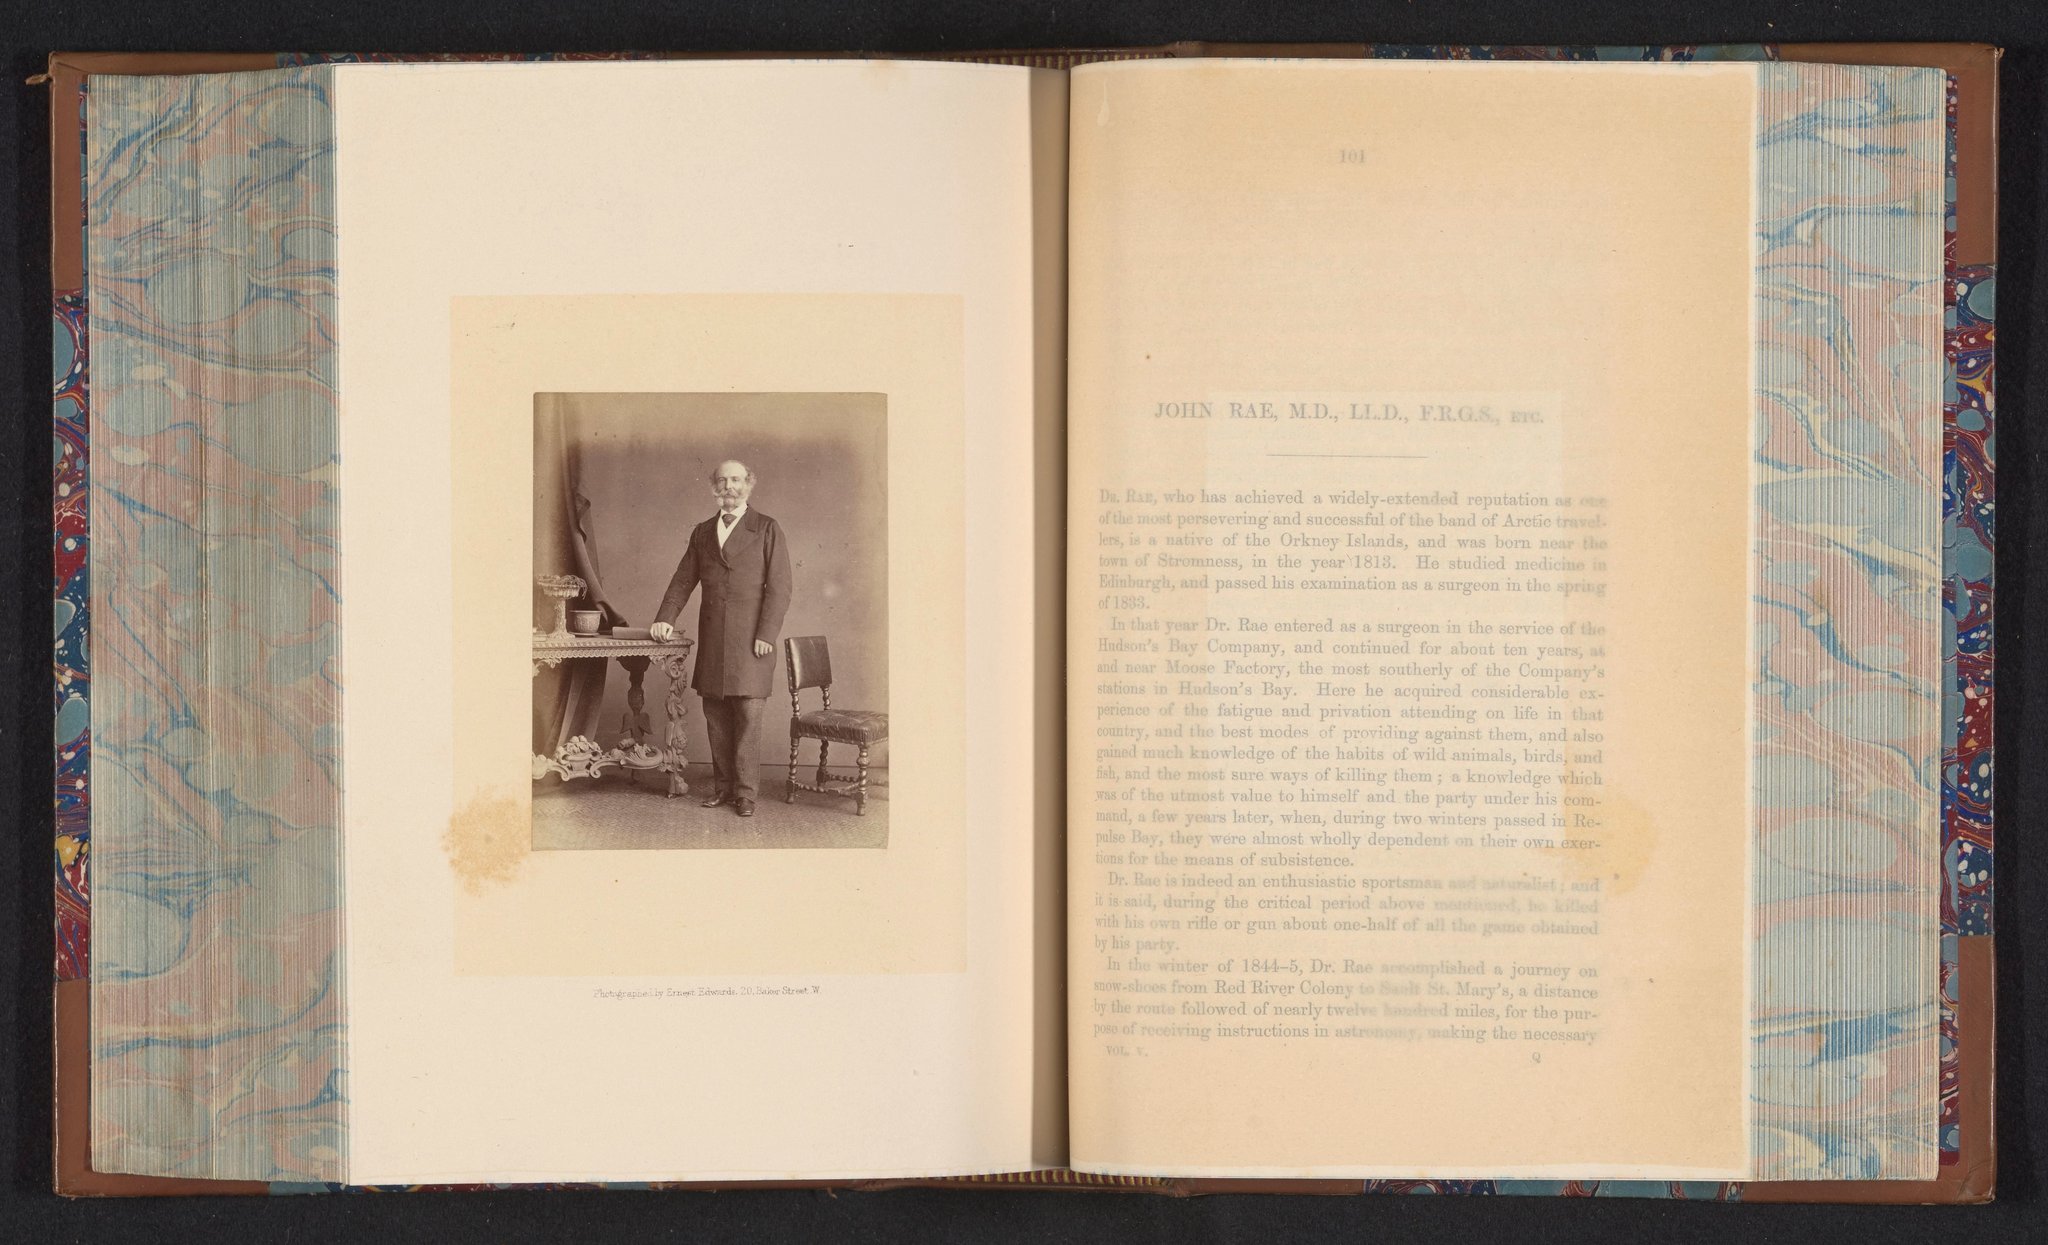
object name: page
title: Portret van John Rae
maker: ernest edwards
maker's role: fotograaf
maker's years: 1837-1903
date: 1856-1866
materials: photographic support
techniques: albumen print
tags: studio requisites ~ photographer, explorer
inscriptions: name: ‘Photographed by Ernest Edwards, 20, Baker Street. W.’